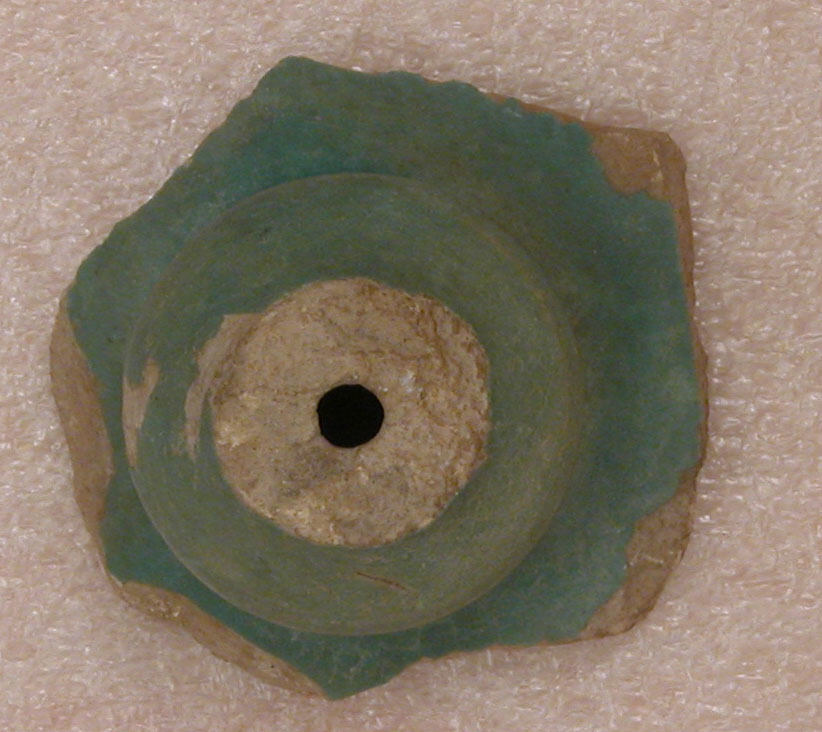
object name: tile fragment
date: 1334-1434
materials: glaze, stonepaste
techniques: painting, polychrome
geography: uzbekistan